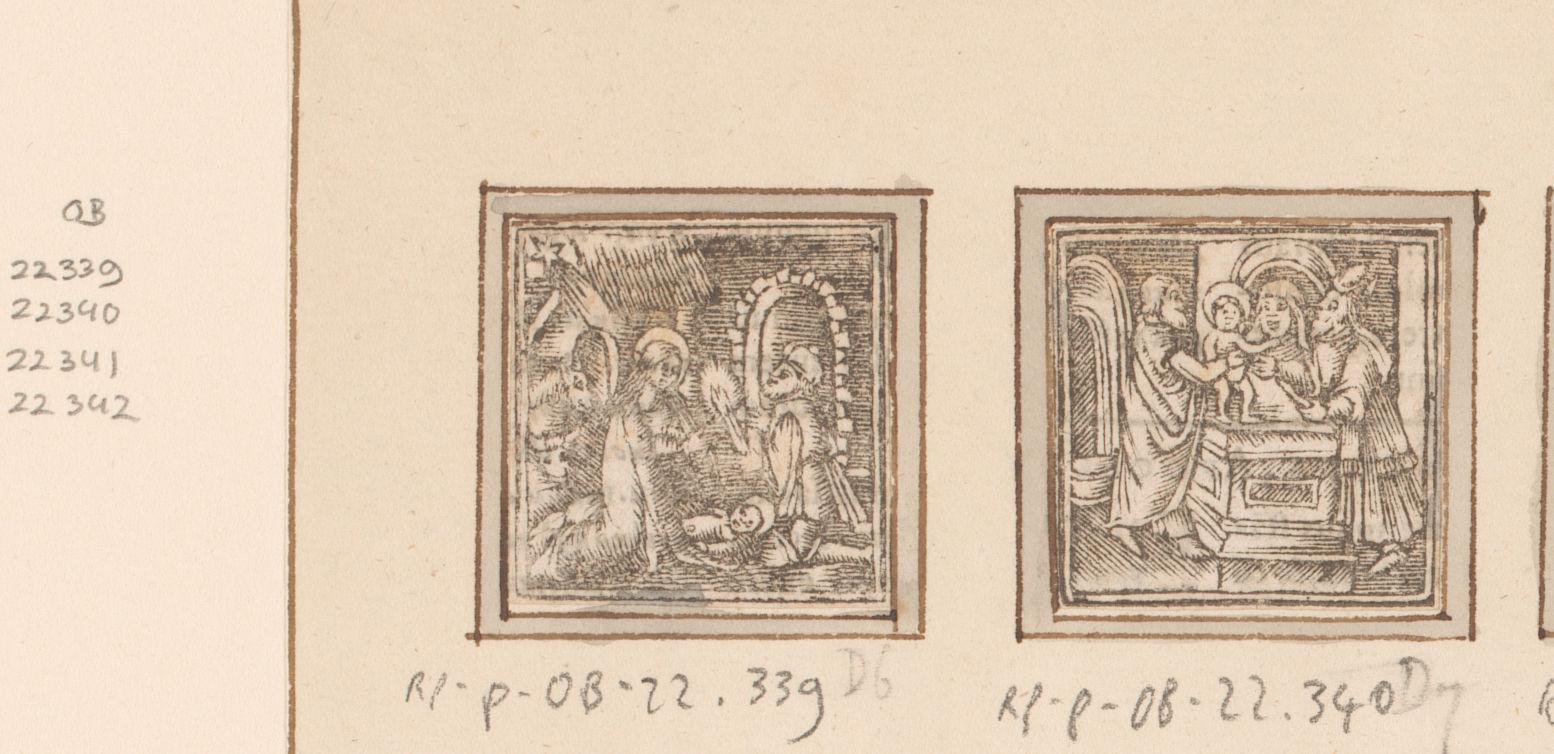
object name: print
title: Bijbelillustraties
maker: Anonymous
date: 1590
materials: paper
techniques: woodcut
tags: mary, joseph and the new-born christ (nativity)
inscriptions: collector's mark: Lugt 240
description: Prent afkomstig uit een onbekende Latijnse bijbel, mogelijk gedateerd 1590.